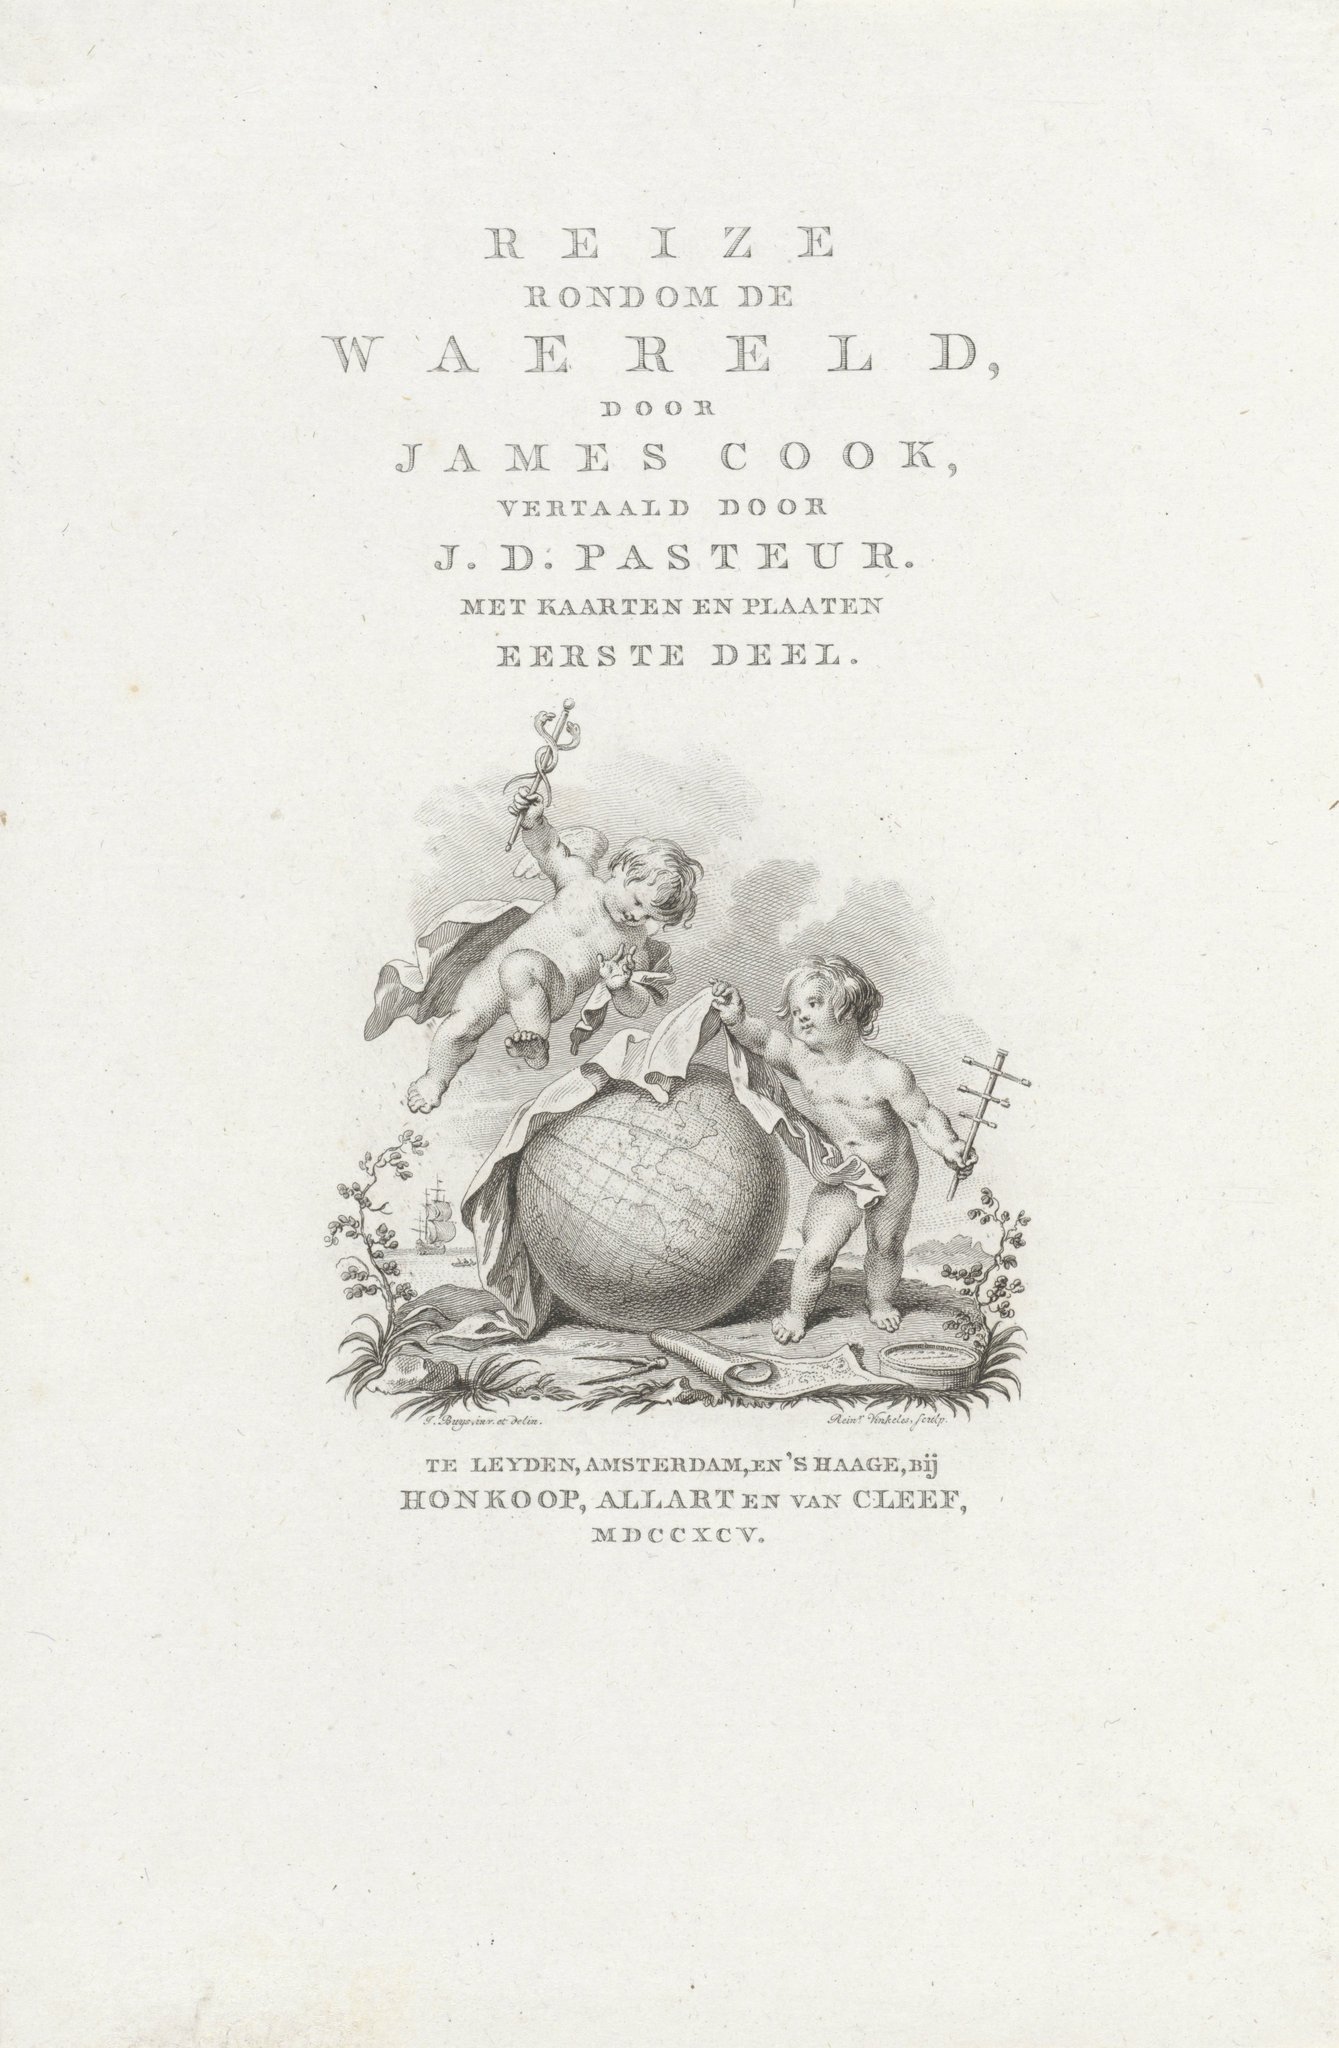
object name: titelblad, titelpagina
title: Titelpagina voor: James Cook, 'Reize rondom de Waereld', 1795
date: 1795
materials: paper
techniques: engraving, etching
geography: amsterdam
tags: earth, world as celestial body, attributes of mercury, cupids: 'amores', 'amoretti', 'putti'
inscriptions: collector's mark: Lugt 240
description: Titelpagina voor: Cook, James. Reize rondom de Waereld. Leiden: Jan Honkoop, Amsterdam: Johannes Allart, Den Haag: Isaac van Cleef, 1795.